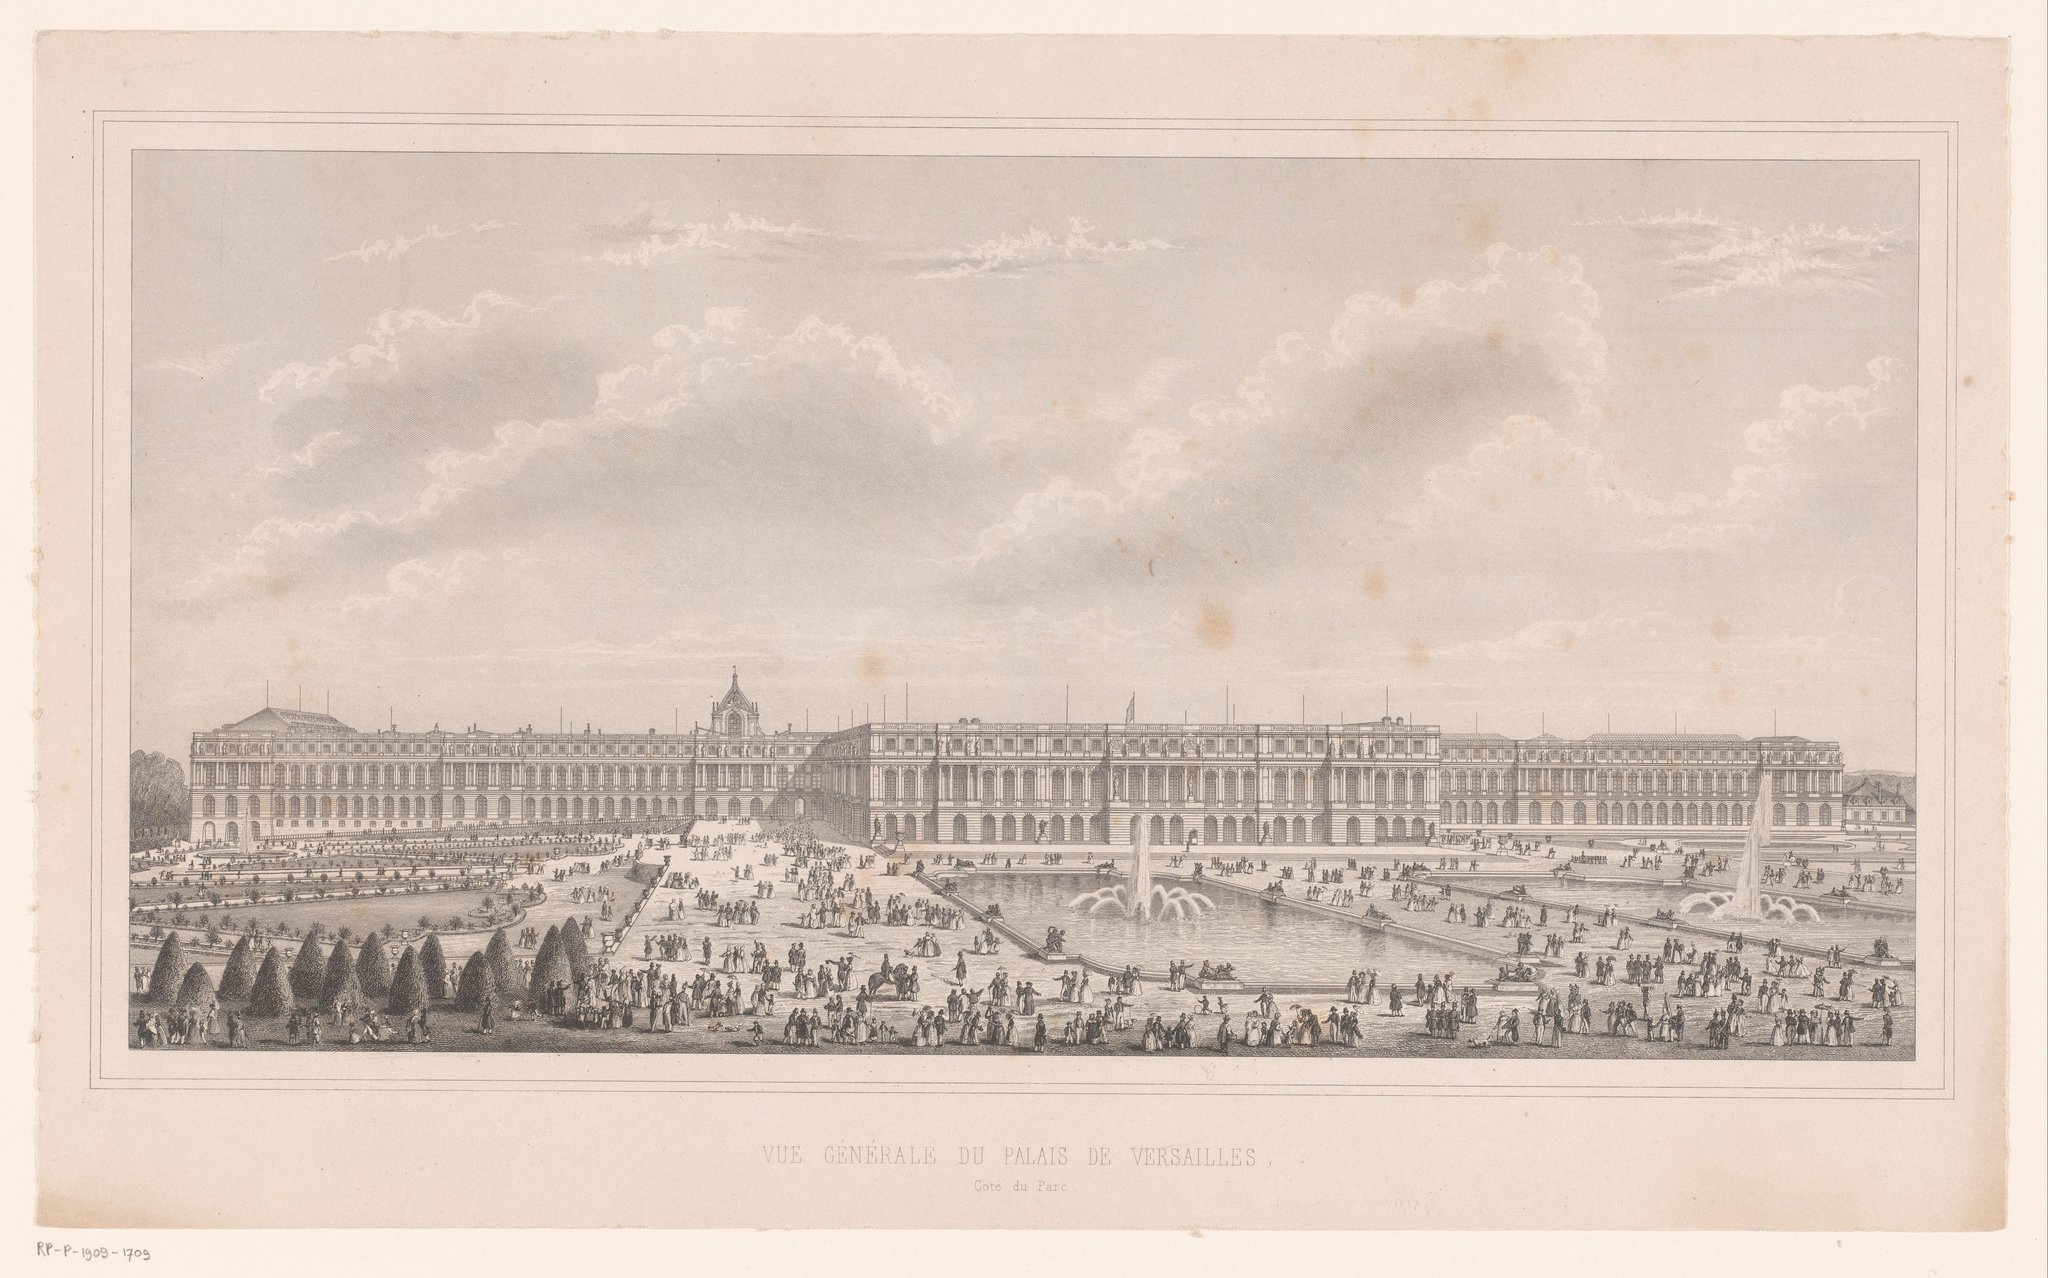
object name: print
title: Vue générale du Palais de Versailles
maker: jacques joseph huguenet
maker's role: print maker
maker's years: 1815-1870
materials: paper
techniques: etching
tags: city-view in general; 'veduta', palace, water-works in garden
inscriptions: collector's mark: Lugt 2228